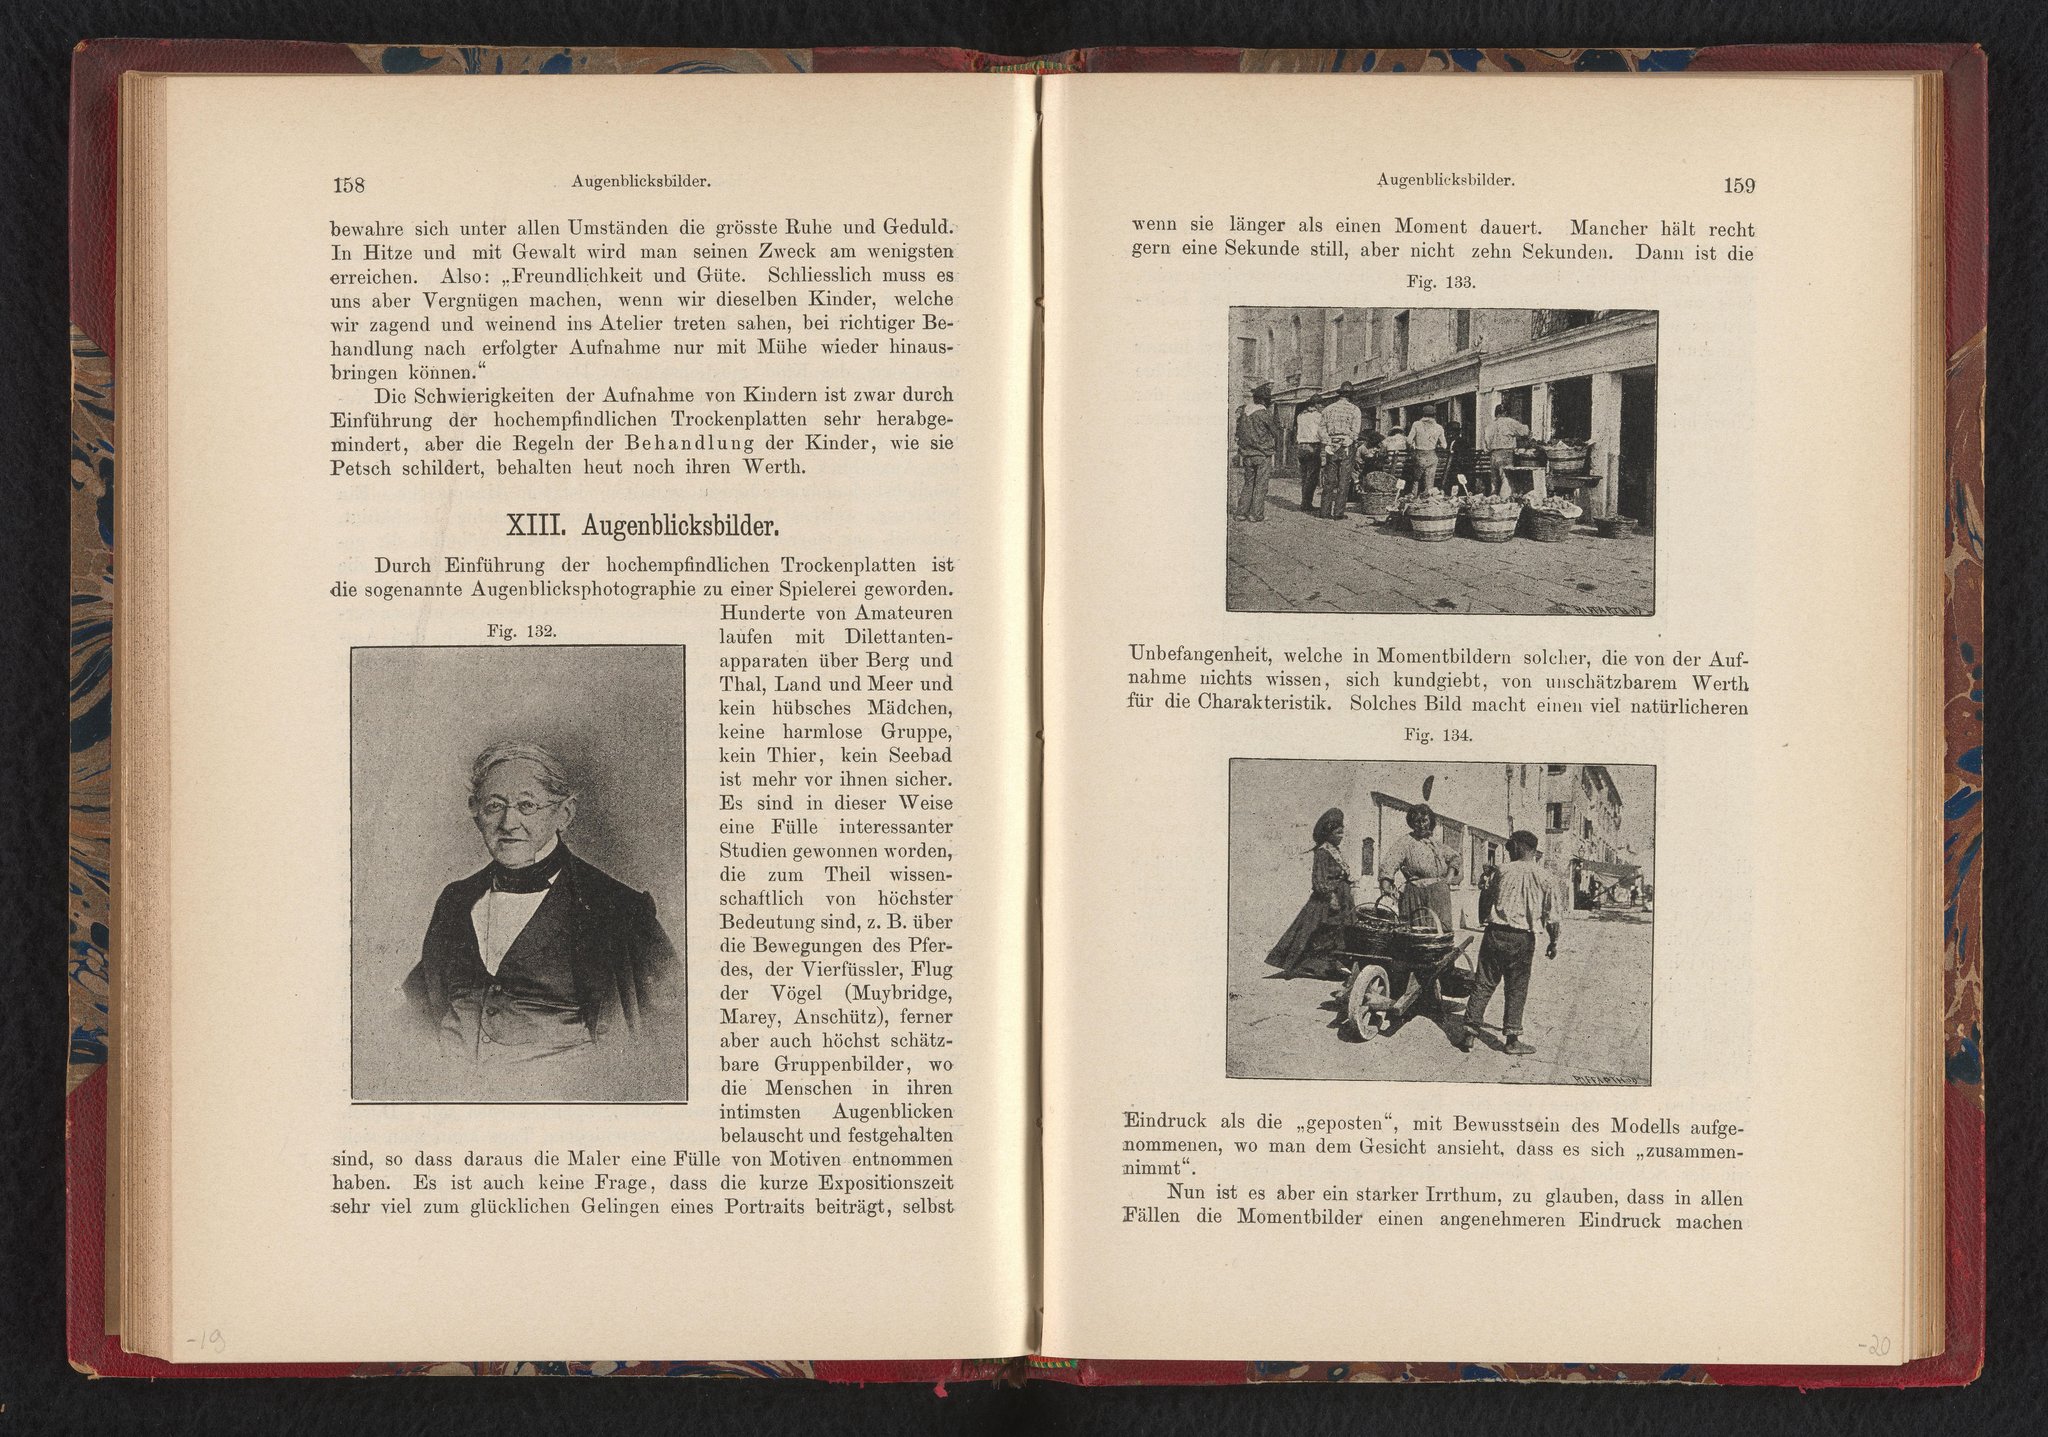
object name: photomechanical print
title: Portret van een onbekende man met bril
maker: Anonymous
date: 1886-1891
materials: paper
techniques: autotype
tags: anonymous historical person portrayed alone